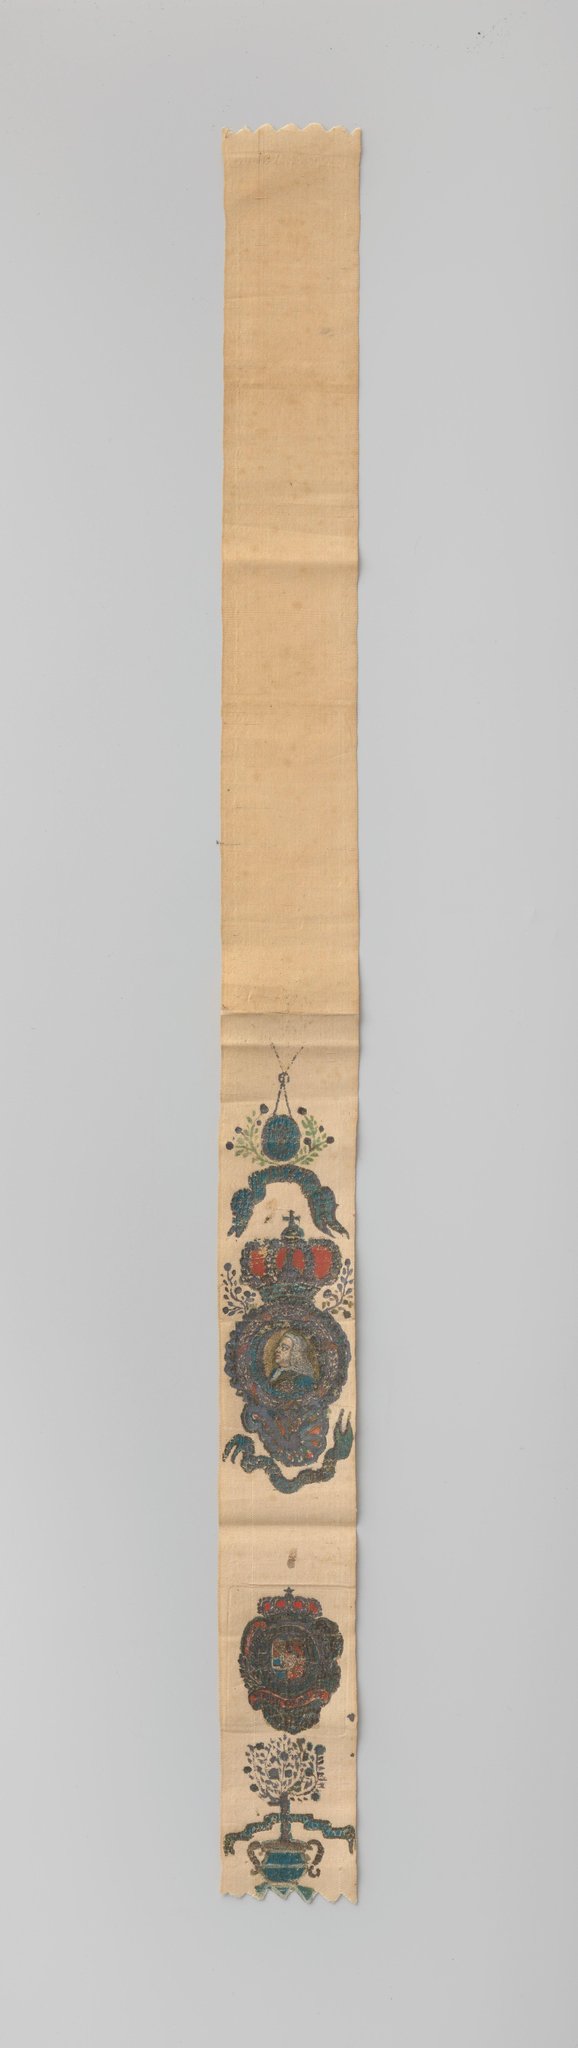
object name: ribbon material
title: Oranjelint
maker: Anonymous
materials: paper, silk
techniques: painted, printing, varnishing, weave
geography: netherlands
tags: the hague, willem iv (prins van oranje-nassau)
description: Oranje lint, de uiteinden gevorkt in zeven punten. Op de onderste helft van boven naar beneden afgebeeld: blauw ovaal schild hangend aan een gekruist touw, omgeven door een krans, eronder blauwe banderol, dan gekroond medaillonportret, borstbeeld van een man (Willem IV), profiel naar links, op papier, uitgeknipt en opgeplakt, daaronder onduidelijk ornament, dan blauwe banderol, dan gekroond en omkranst wapen, dan oranjeboom in blauwe vaas met grote oren en een blauw lint. Opschrift onleesbaar.